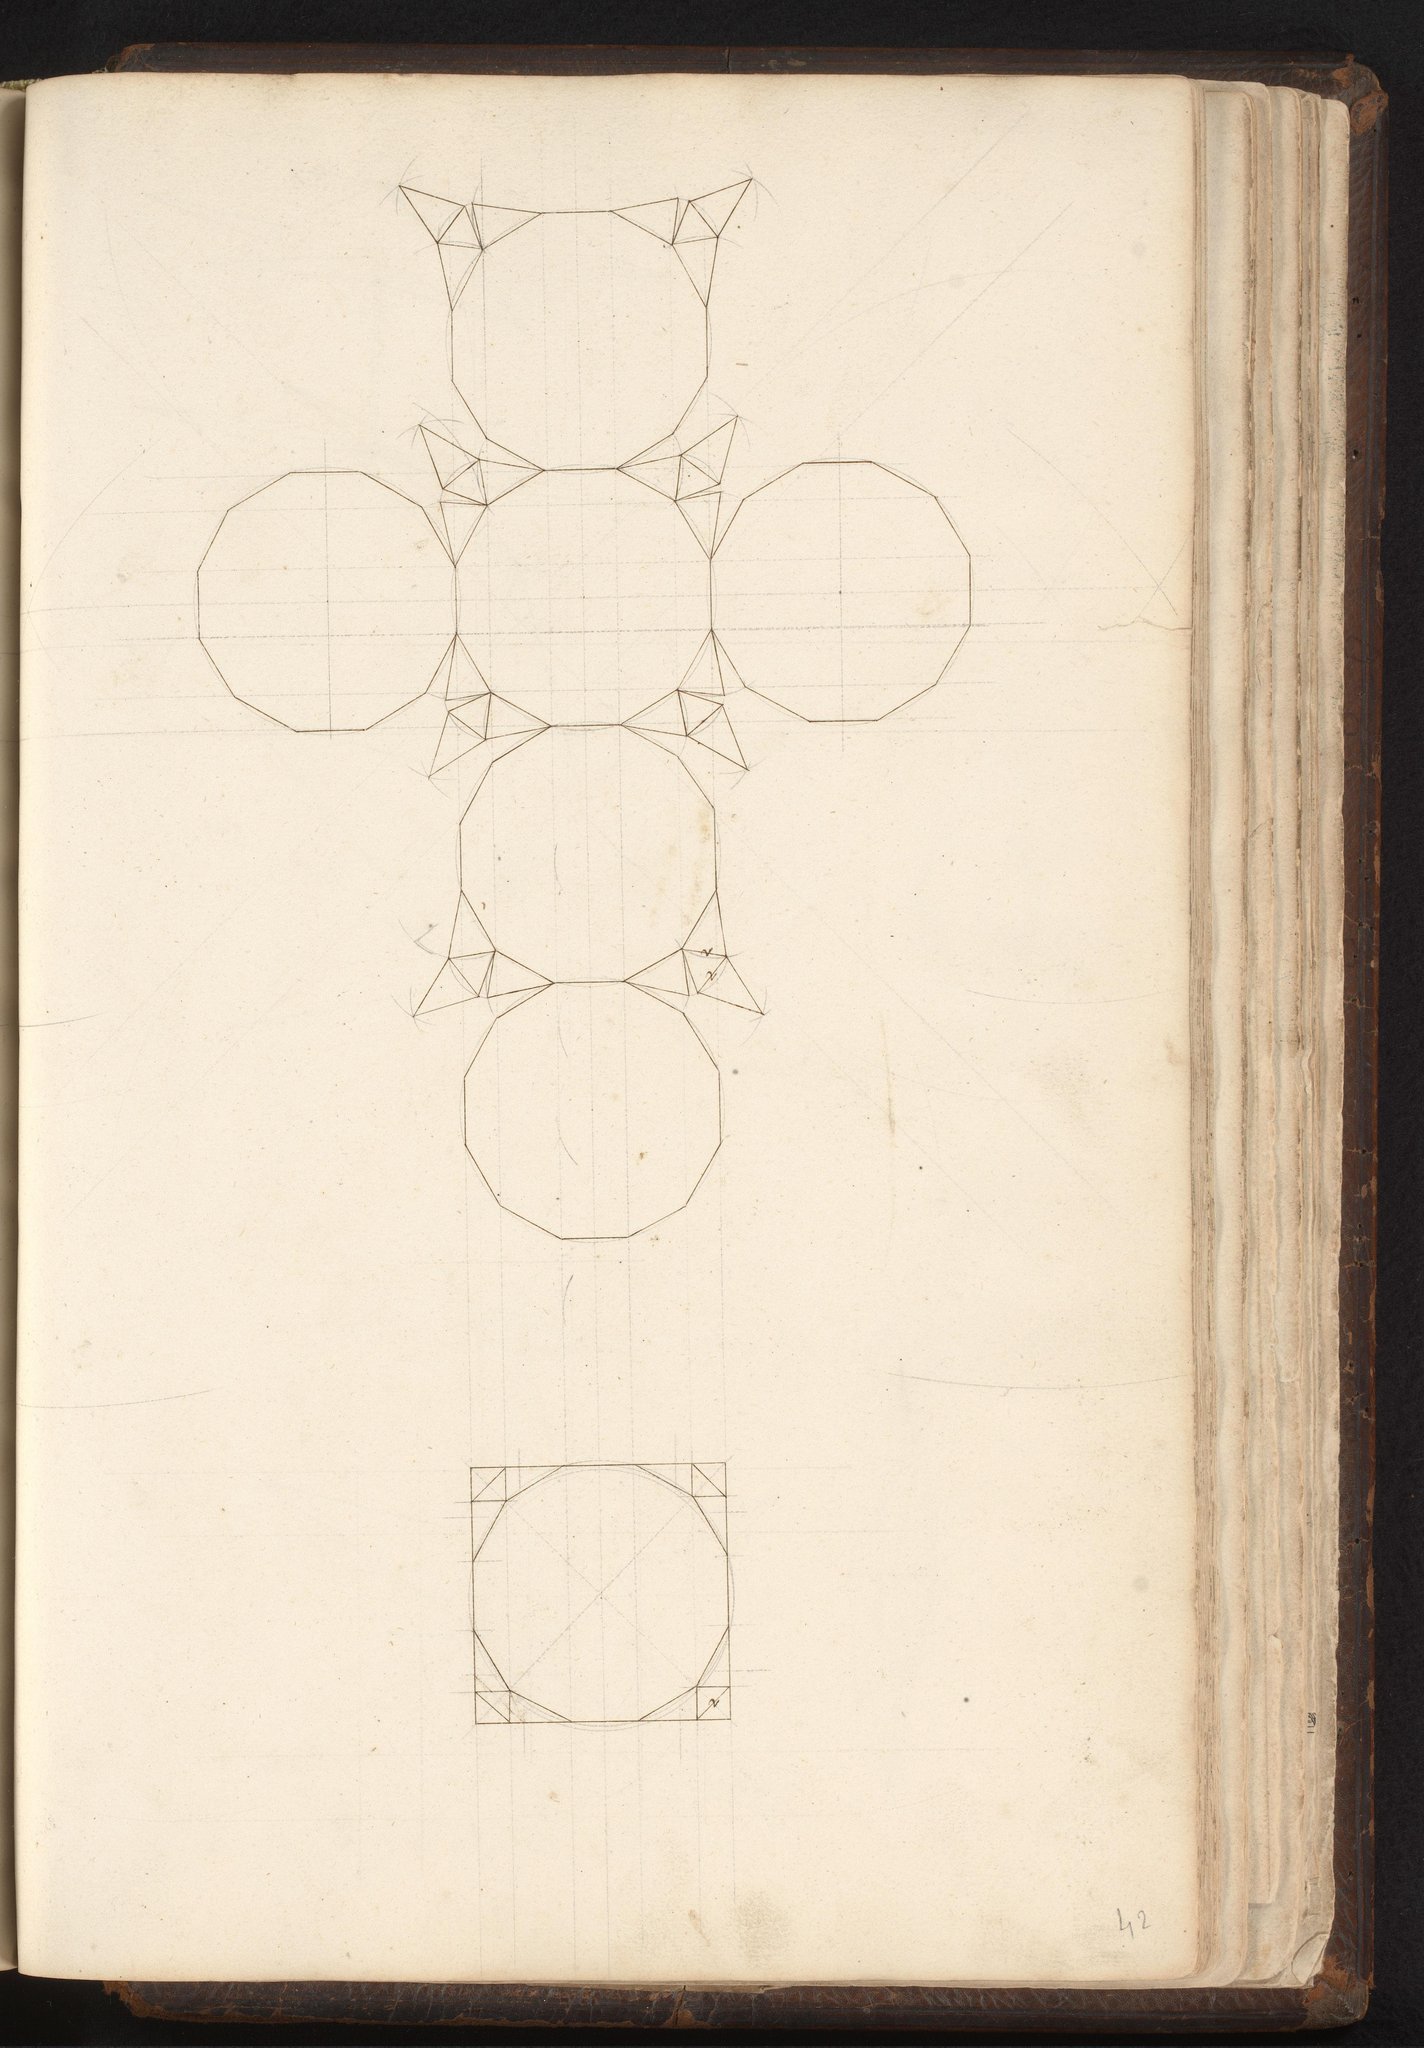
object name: drawing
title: Geometrische figuren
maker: Anonymous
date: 1650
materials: ink, paper, pencil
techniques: pen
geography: low countries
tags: planimetry, geometry